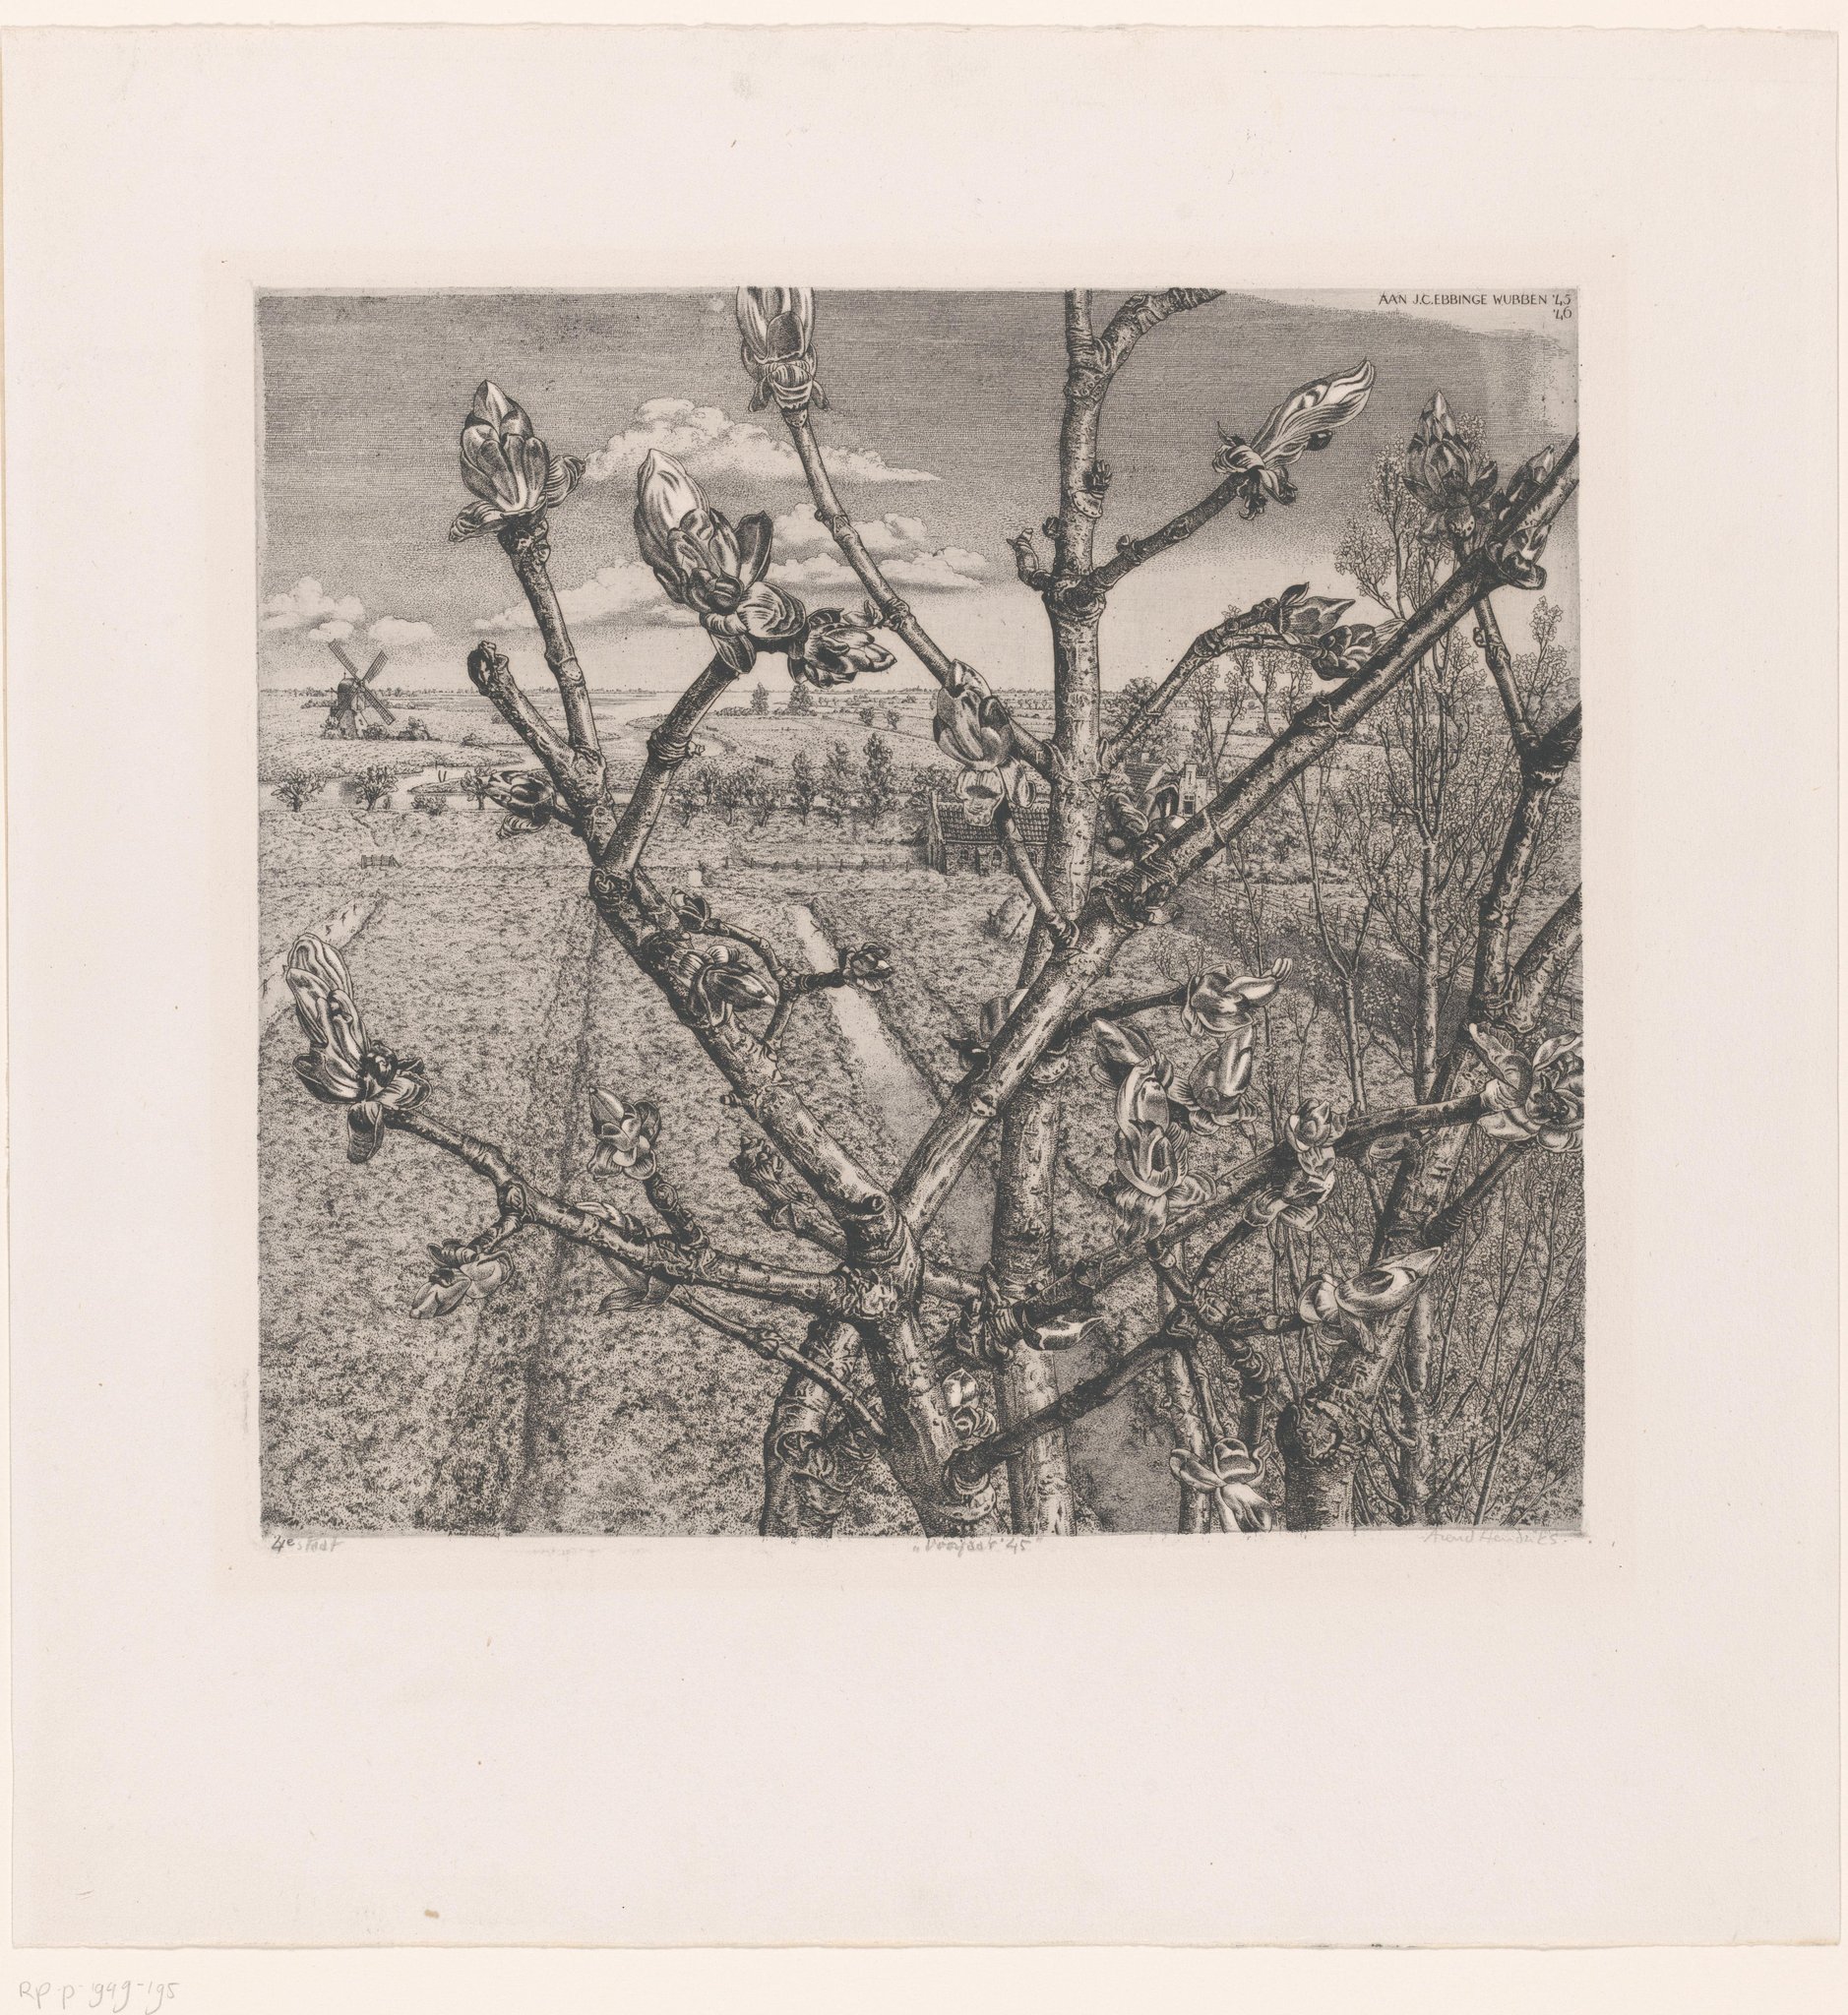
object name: print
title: Voorjaar '45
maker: arend hendriks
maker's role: print maker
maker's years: 1901-1951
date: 1946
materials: paper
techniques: etching, intaglio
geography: netherlands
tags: winter landscape; landscape symbolizing winter (the four seasons of the year)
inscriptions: inscription: ‘4e staat’, collector's mark: Lugt 2228